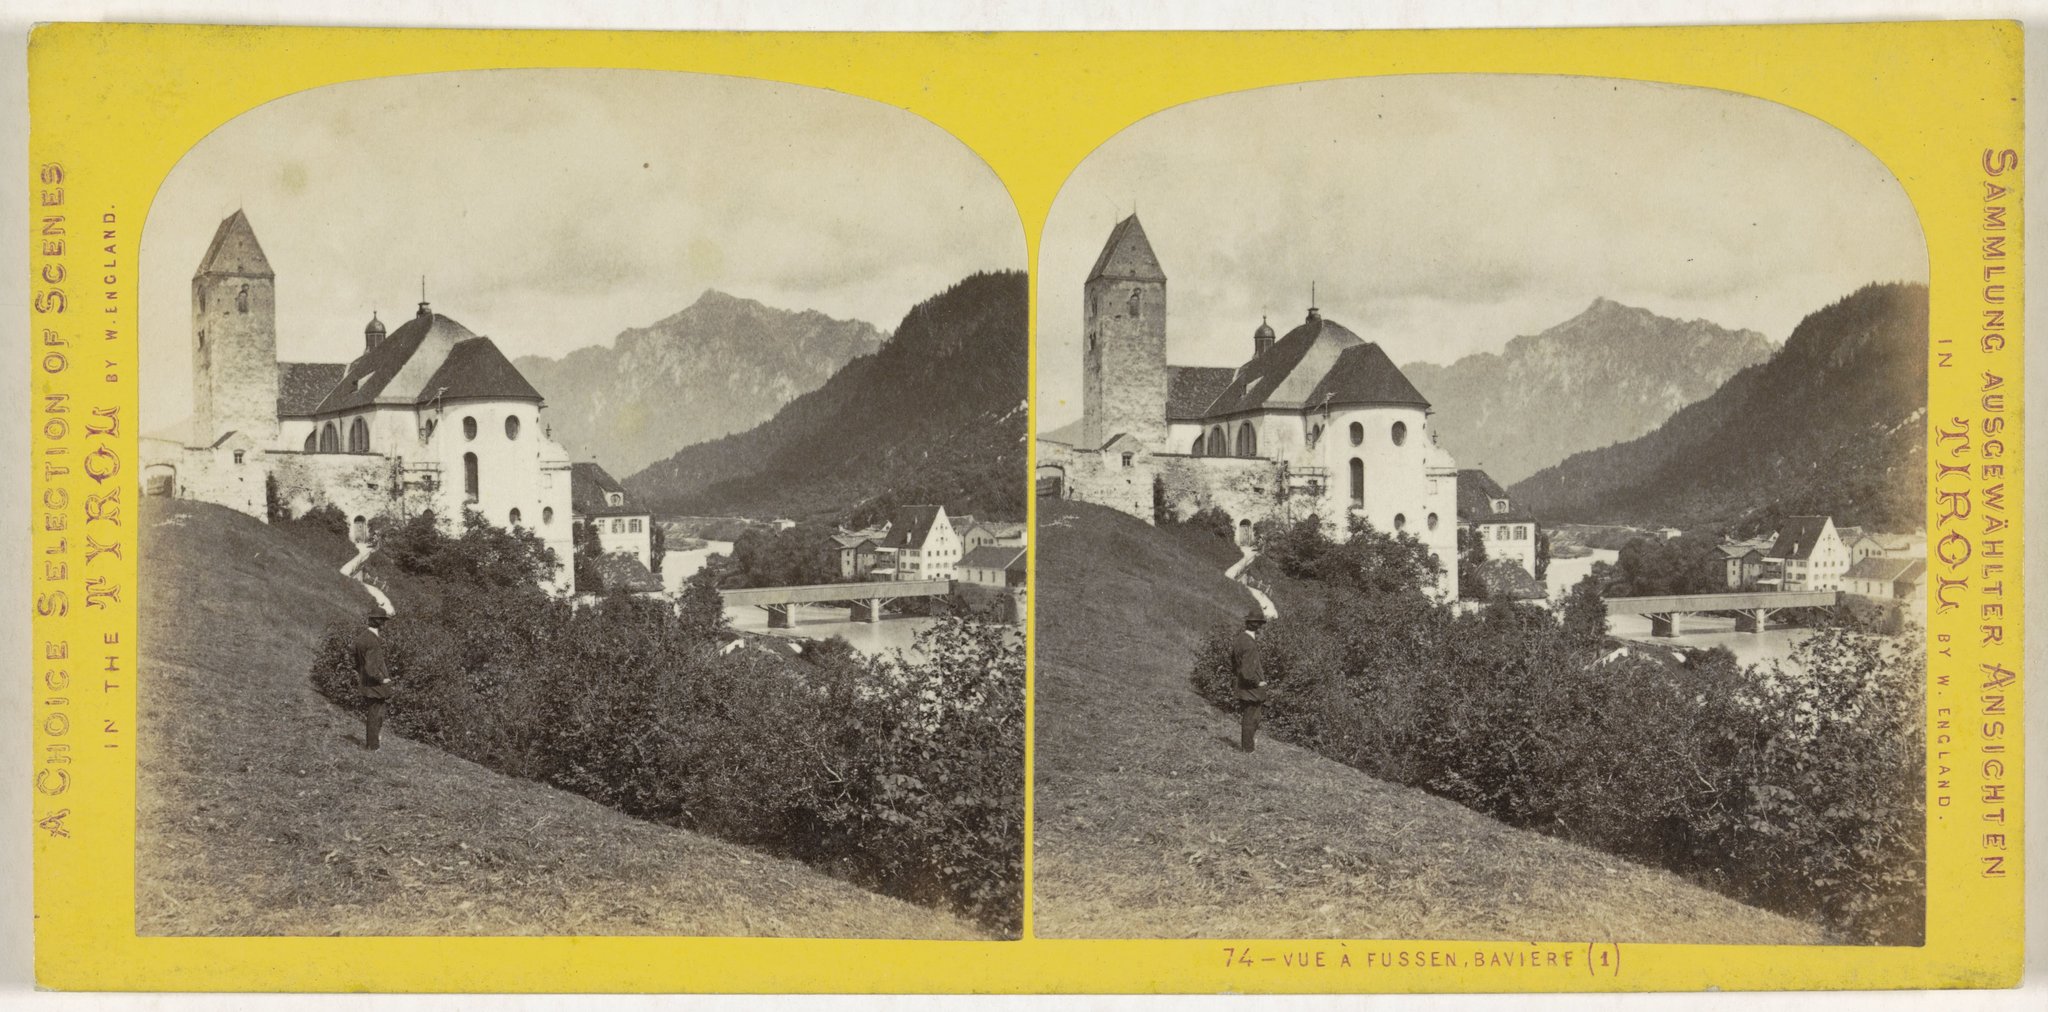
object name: stereograph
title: A Choice Selection of Scenes in the Tyrol / Sammlung ausgewählter Ansichten in Tirol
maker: william england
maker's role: fotograaf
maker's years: 1816-1896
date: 1863-1865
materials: cardboard, paper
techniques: albumen print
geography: fussen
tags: abbey, monastery, convent ~ roman catholic church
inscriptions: number: ‘74’